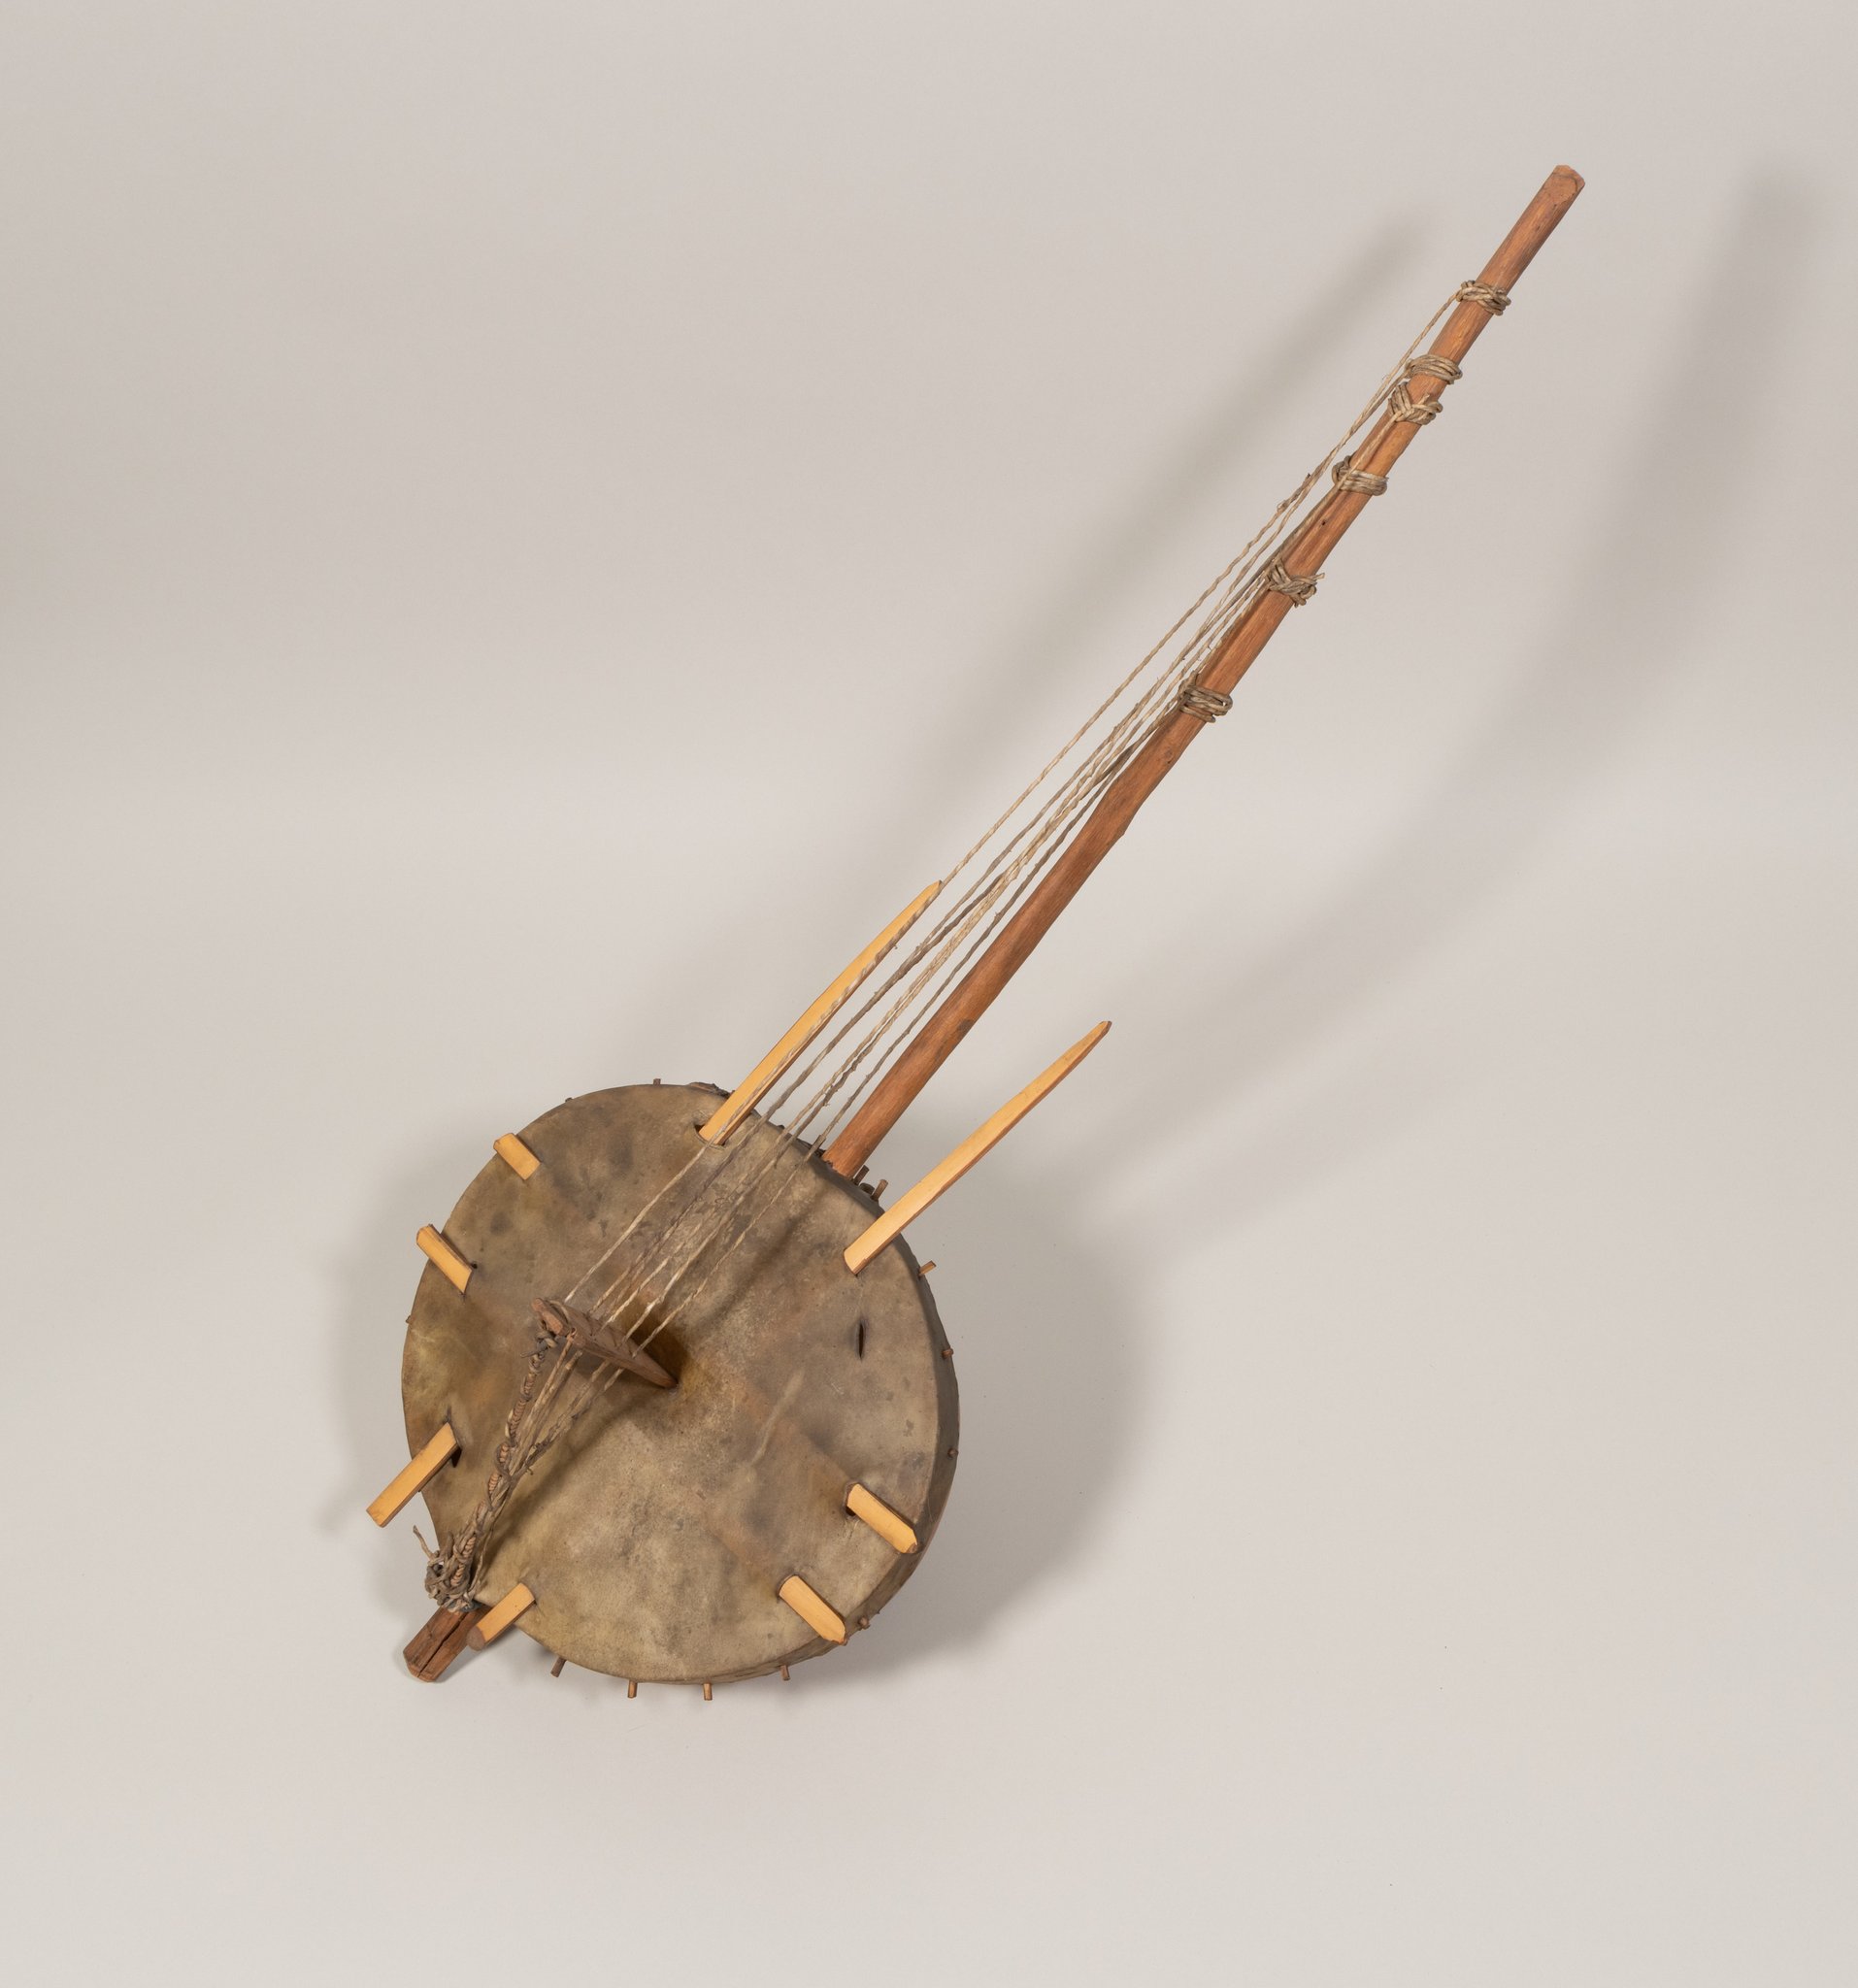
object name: sora ngoni simbingo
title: Sora Ngoni (Simbingo)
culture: loma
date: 1801-1900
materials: leather, skin, wood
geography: guinea